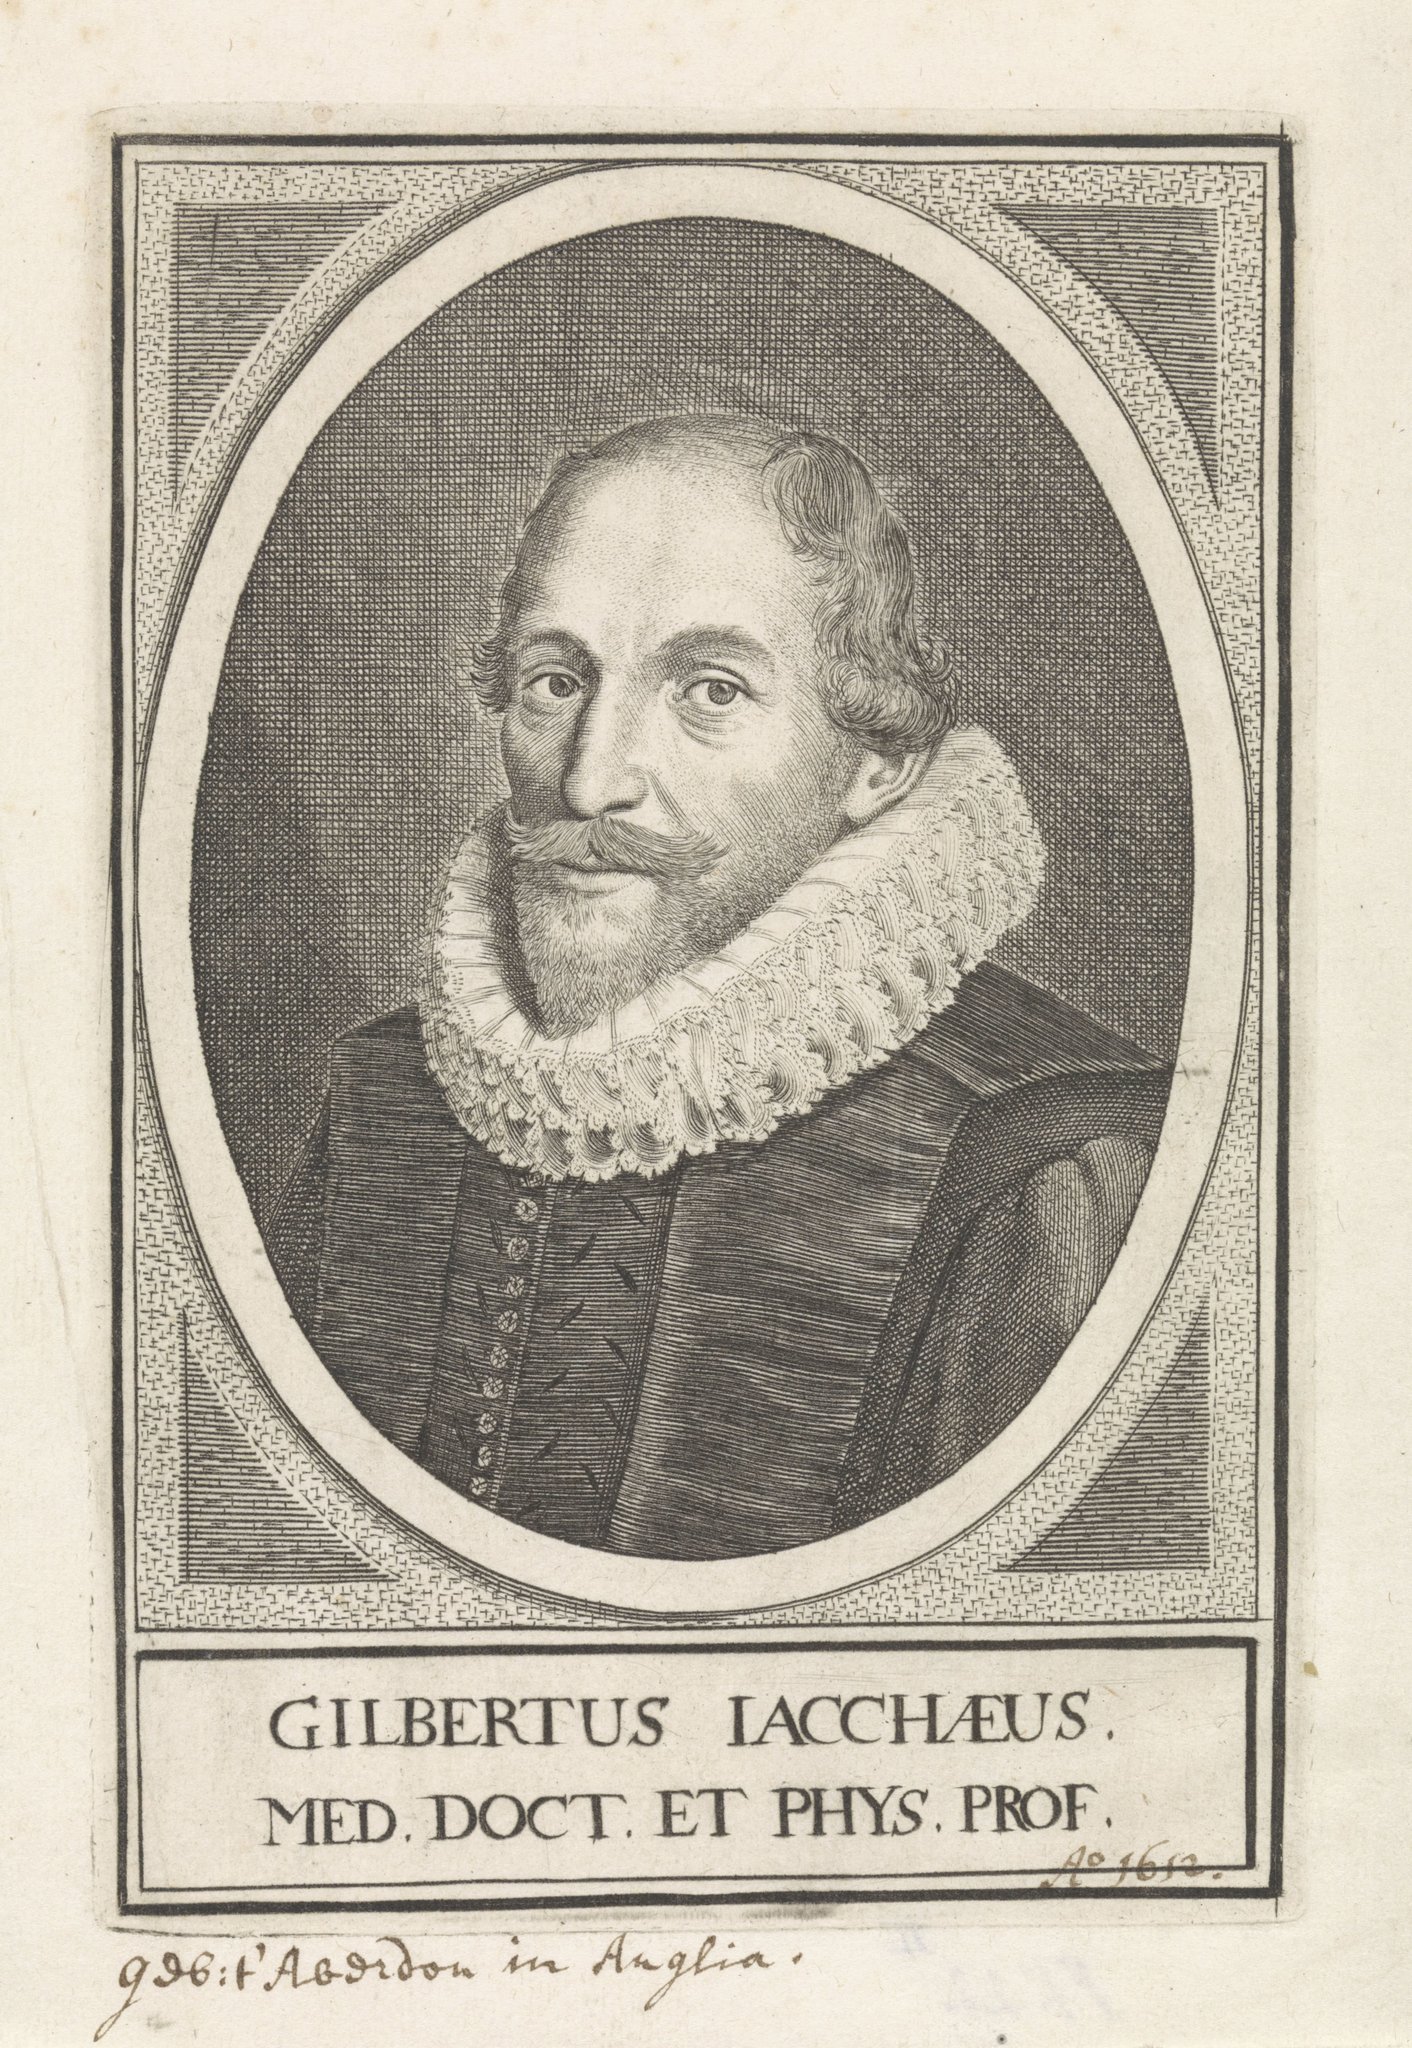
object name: print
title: Portret van Jacchaeus Gilbertus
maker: de passe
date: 1625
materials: paper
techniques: engraving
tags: leiden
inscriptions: inscription: ‘Ao 1612’, collector's mark: Lugt 2228, inscription: ‘geb: t' Aberdon in Anglia’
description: Prent ook gebruikt als boekillustratie in: Meursius, Joannes. Athenæ Batavæ. Sive, De vrbe Leidensi, & academiâ, virisque claris. Leiden: Andries Clouck, Bonaventura en Abraham Elzevier, 1625.